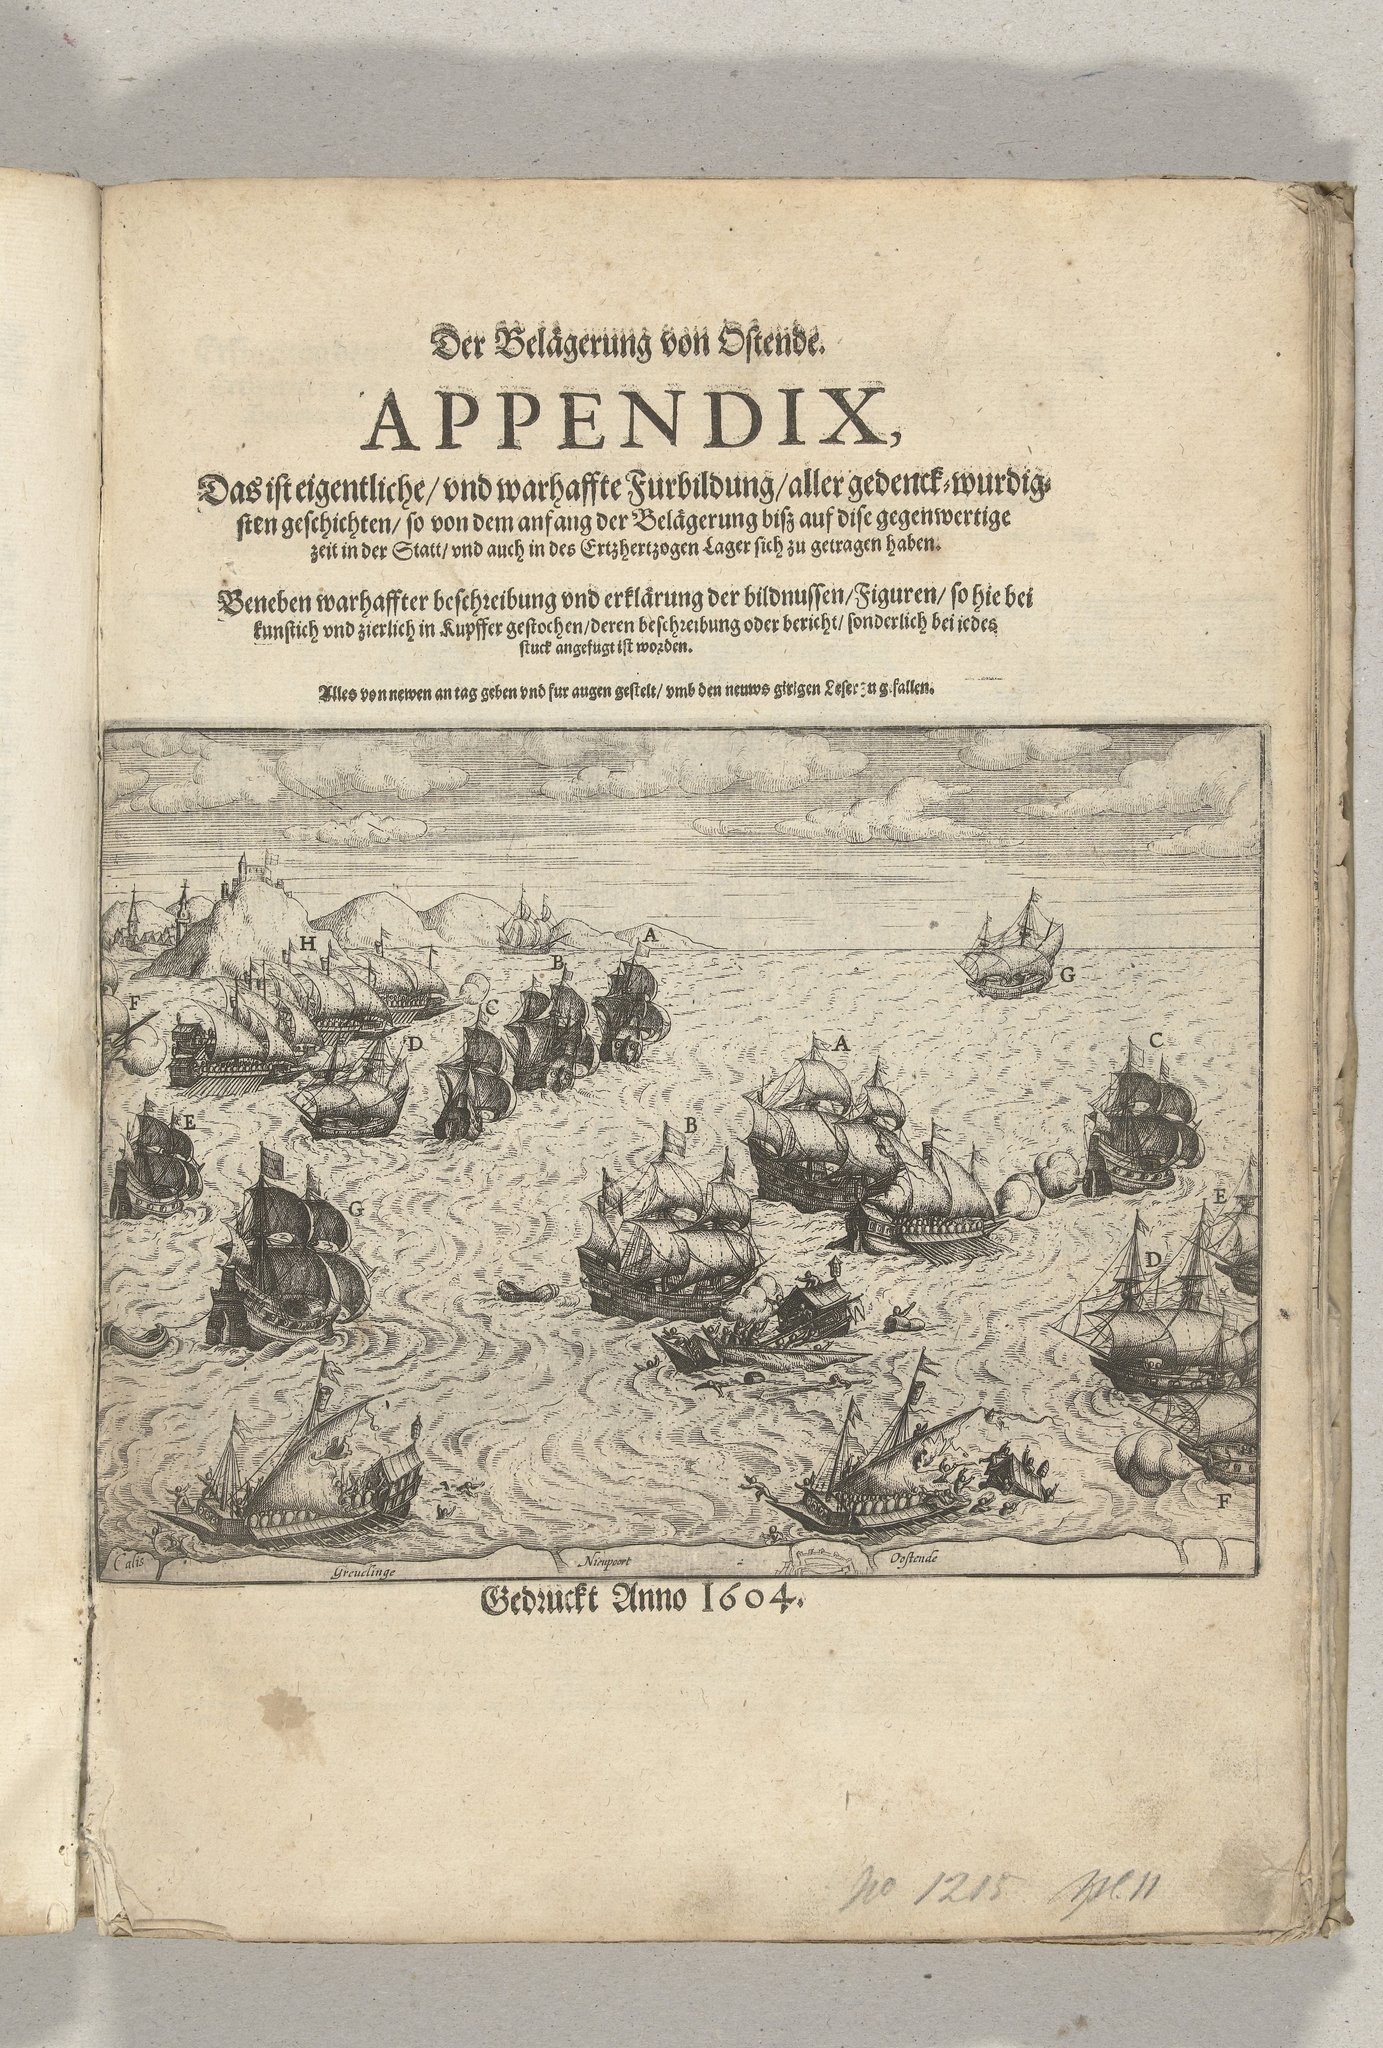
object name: print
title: Titelprent voor de Appendix: de vernietiging van Spaanse galeien, 3 oktober 1602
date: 1602-1604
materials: paper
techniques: etching, letterpress printing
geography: low countries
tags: battle (+ naval force), warfare; military affairs (+ oared ships, e.g.: galley), trireme, galley, english channel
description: Onderdeel van illustraties in: Belaegerung der Statt Ostende : Journal: Tagregister... aller gedenckwurdigsten Sachen... so inner und ausserhalb... sich zugetragen... von 5 July 1601. biss auff diese.. Herbstmisse Anno 1604... auss der Niderlendischen in die Hochteutsche Sprach transferirt, Und mit: Journal. Ander theil uber die Belägerung der statt Ostende biss auf die Herbstmiss in Sept. 1604 bey gefugt Mappa der Statt Ostende neben dem abriss des Parvae und Novae Troiae, s.l., 1604, fol°, ill. Hierbij gevoegd enkele prenten voorzien van Duitse teksten, 1604 (z.n., z.p.), titelprent Appendix. In het exemplaar in de collectie van de Rijksmuseum Research Library (326 F 10).